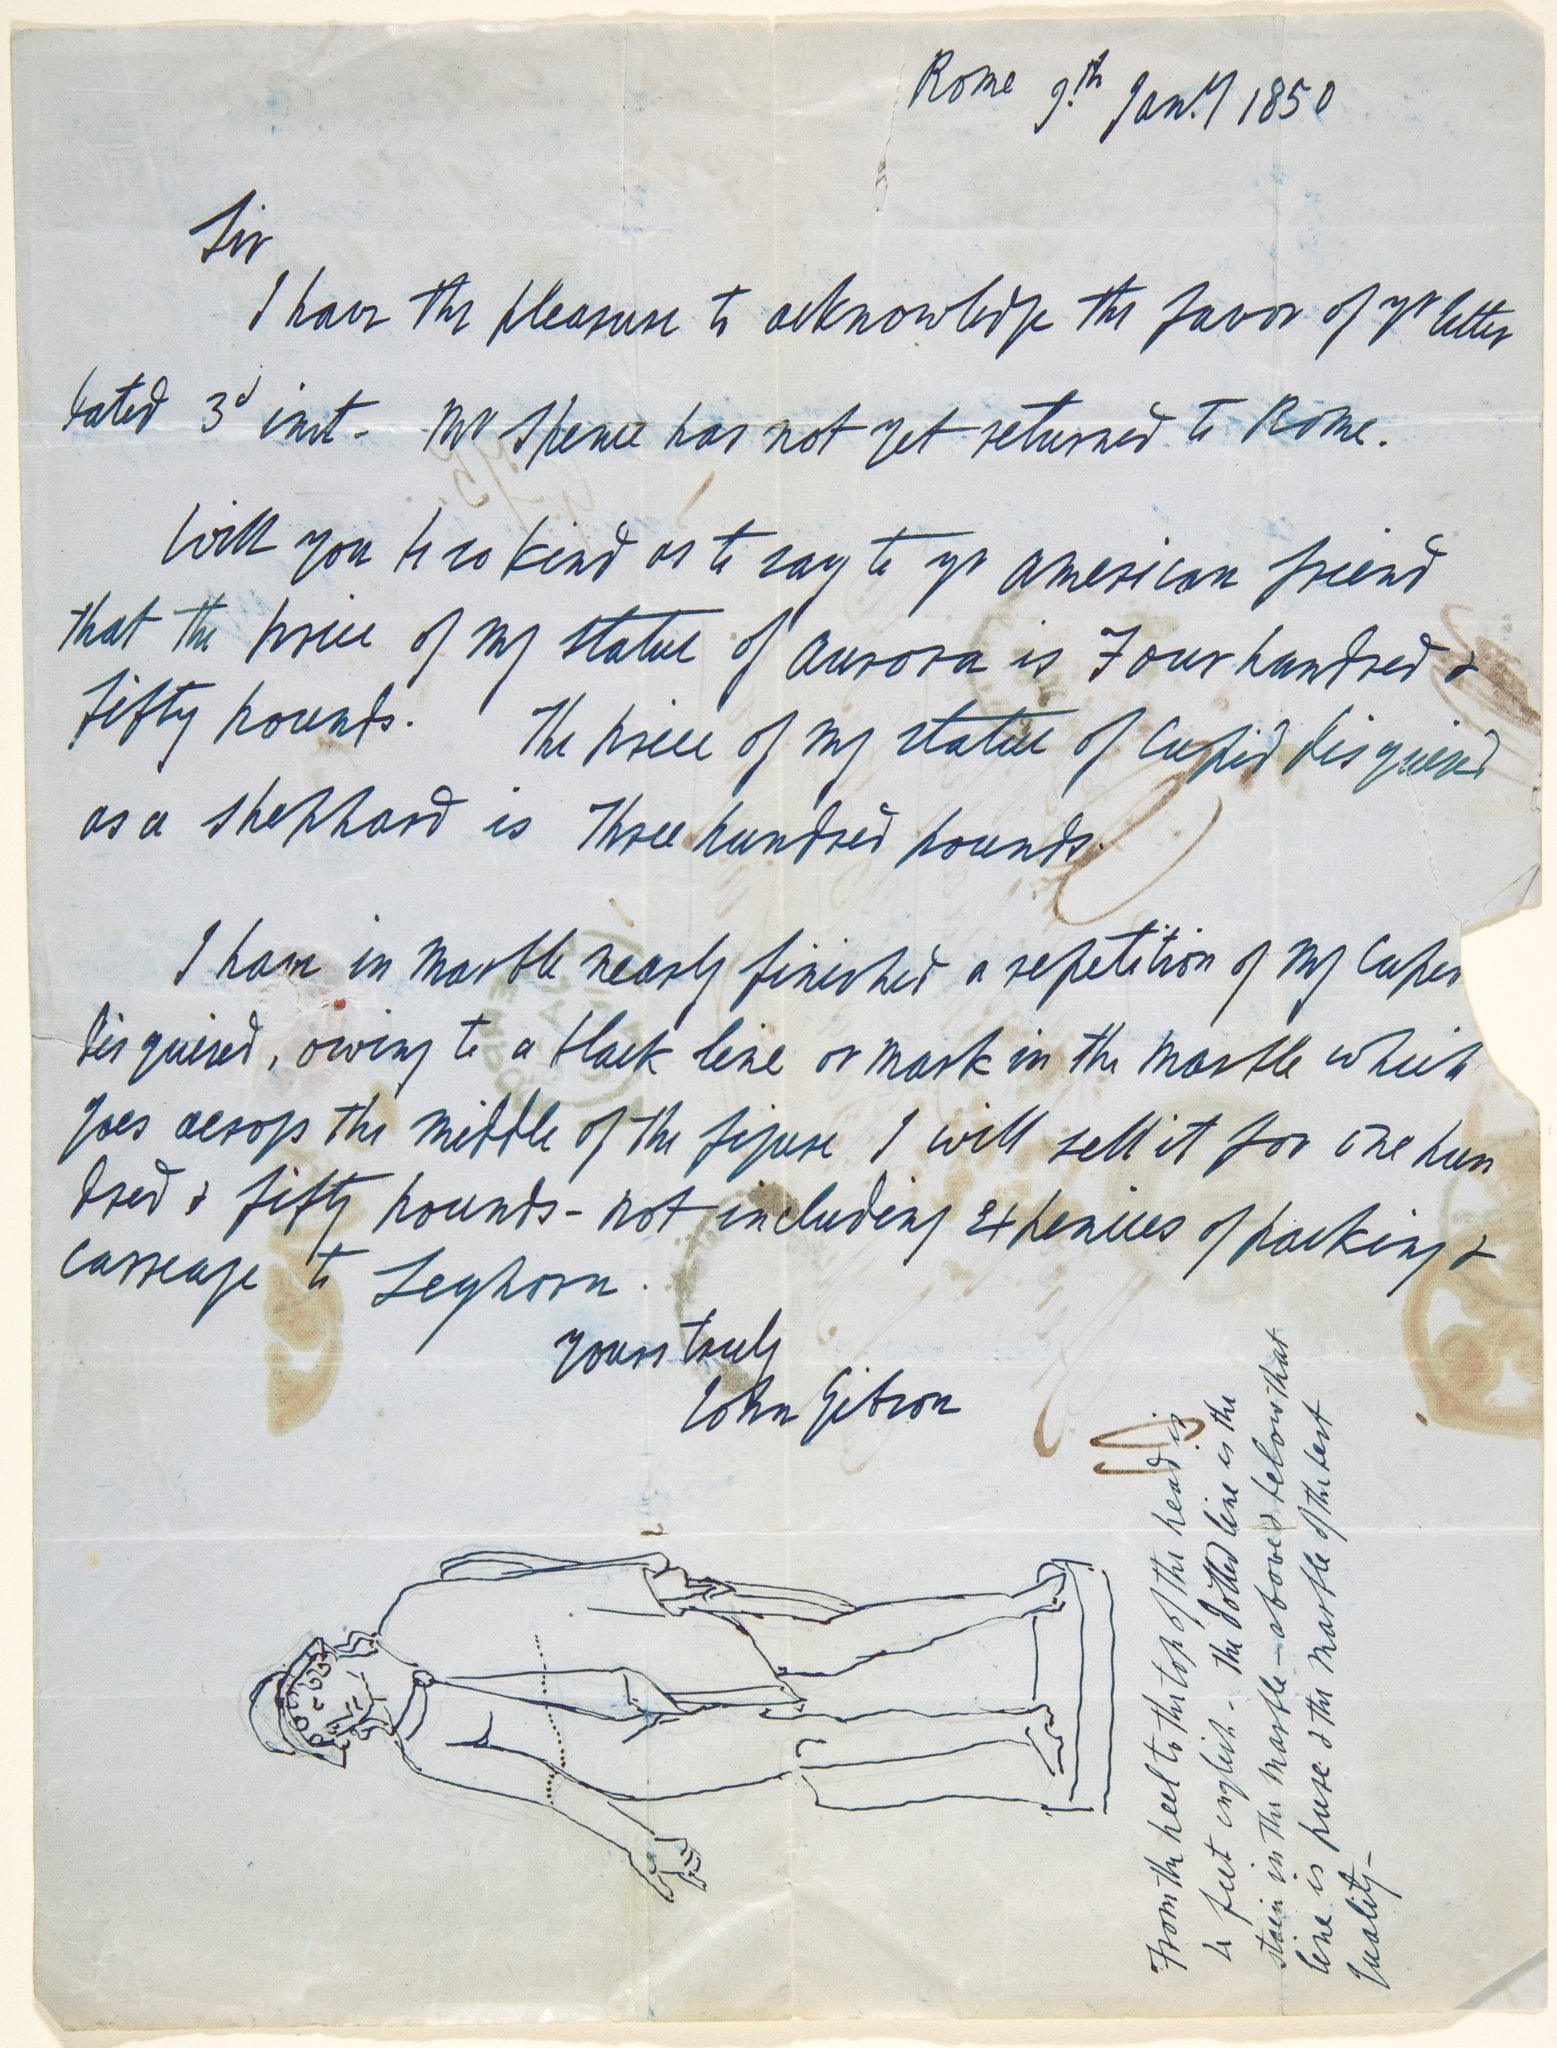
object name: letter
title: Letter from John Gibson to John Udny, containing information for Henry Farnum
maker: john gibson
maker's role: author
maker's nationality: british, born wales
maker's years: 1790-1866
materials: ink, paper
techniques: pen